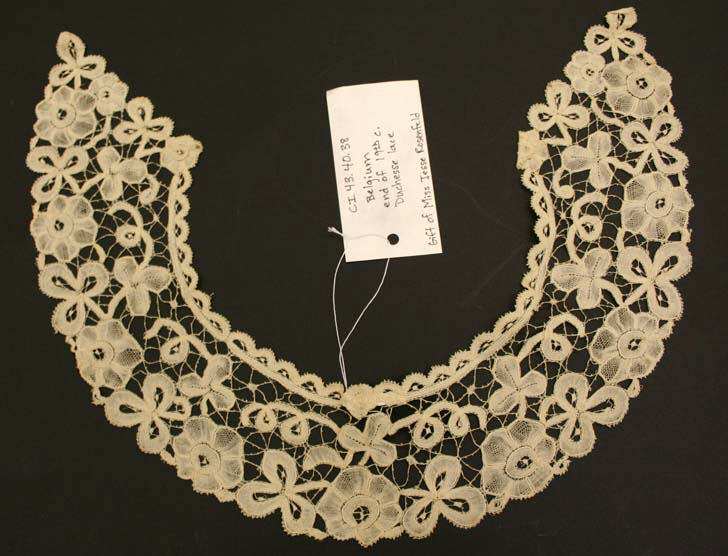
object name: collar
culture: american or european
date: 1700-1943